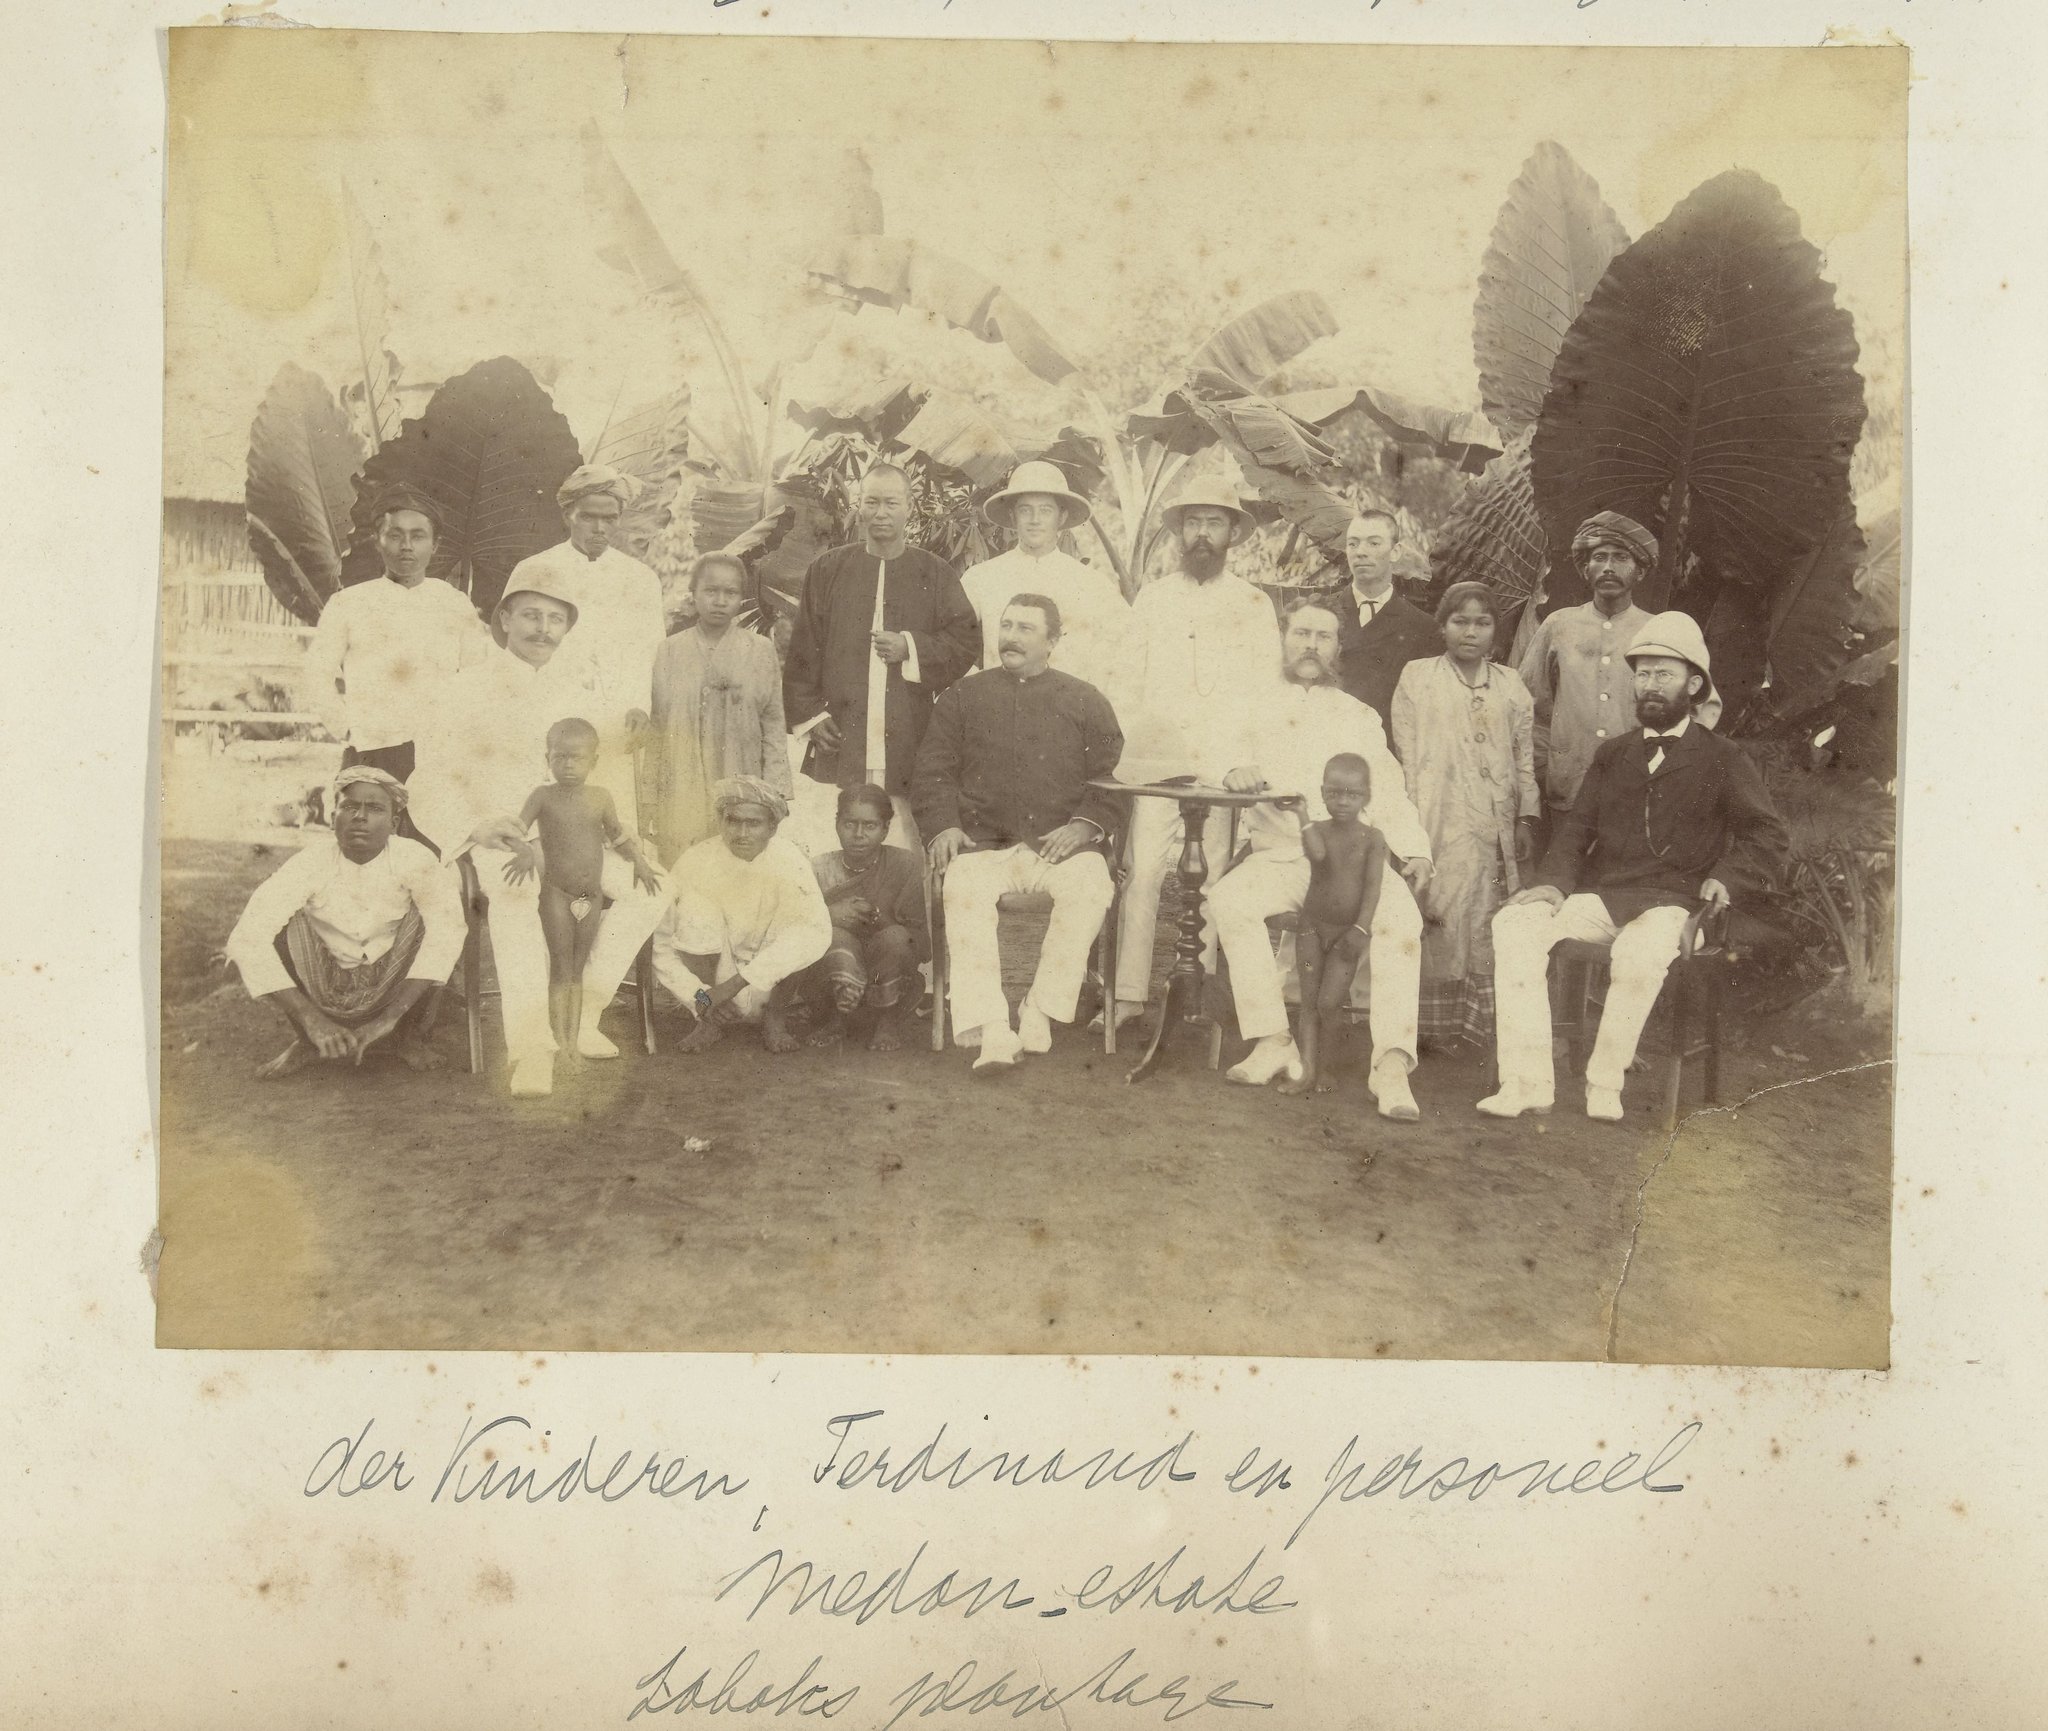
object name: photograph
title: der Kinderen, Ferdinand en personeel Medan-estate tabaks plantage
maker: Anonymous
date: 1890-1910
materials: cardboard, paper, photographic support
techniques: gelatin silver print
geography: netherlands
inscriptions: caption: ‘der Kinderen, Ferdinand en personeel Medan-estate tabaks plantage.’